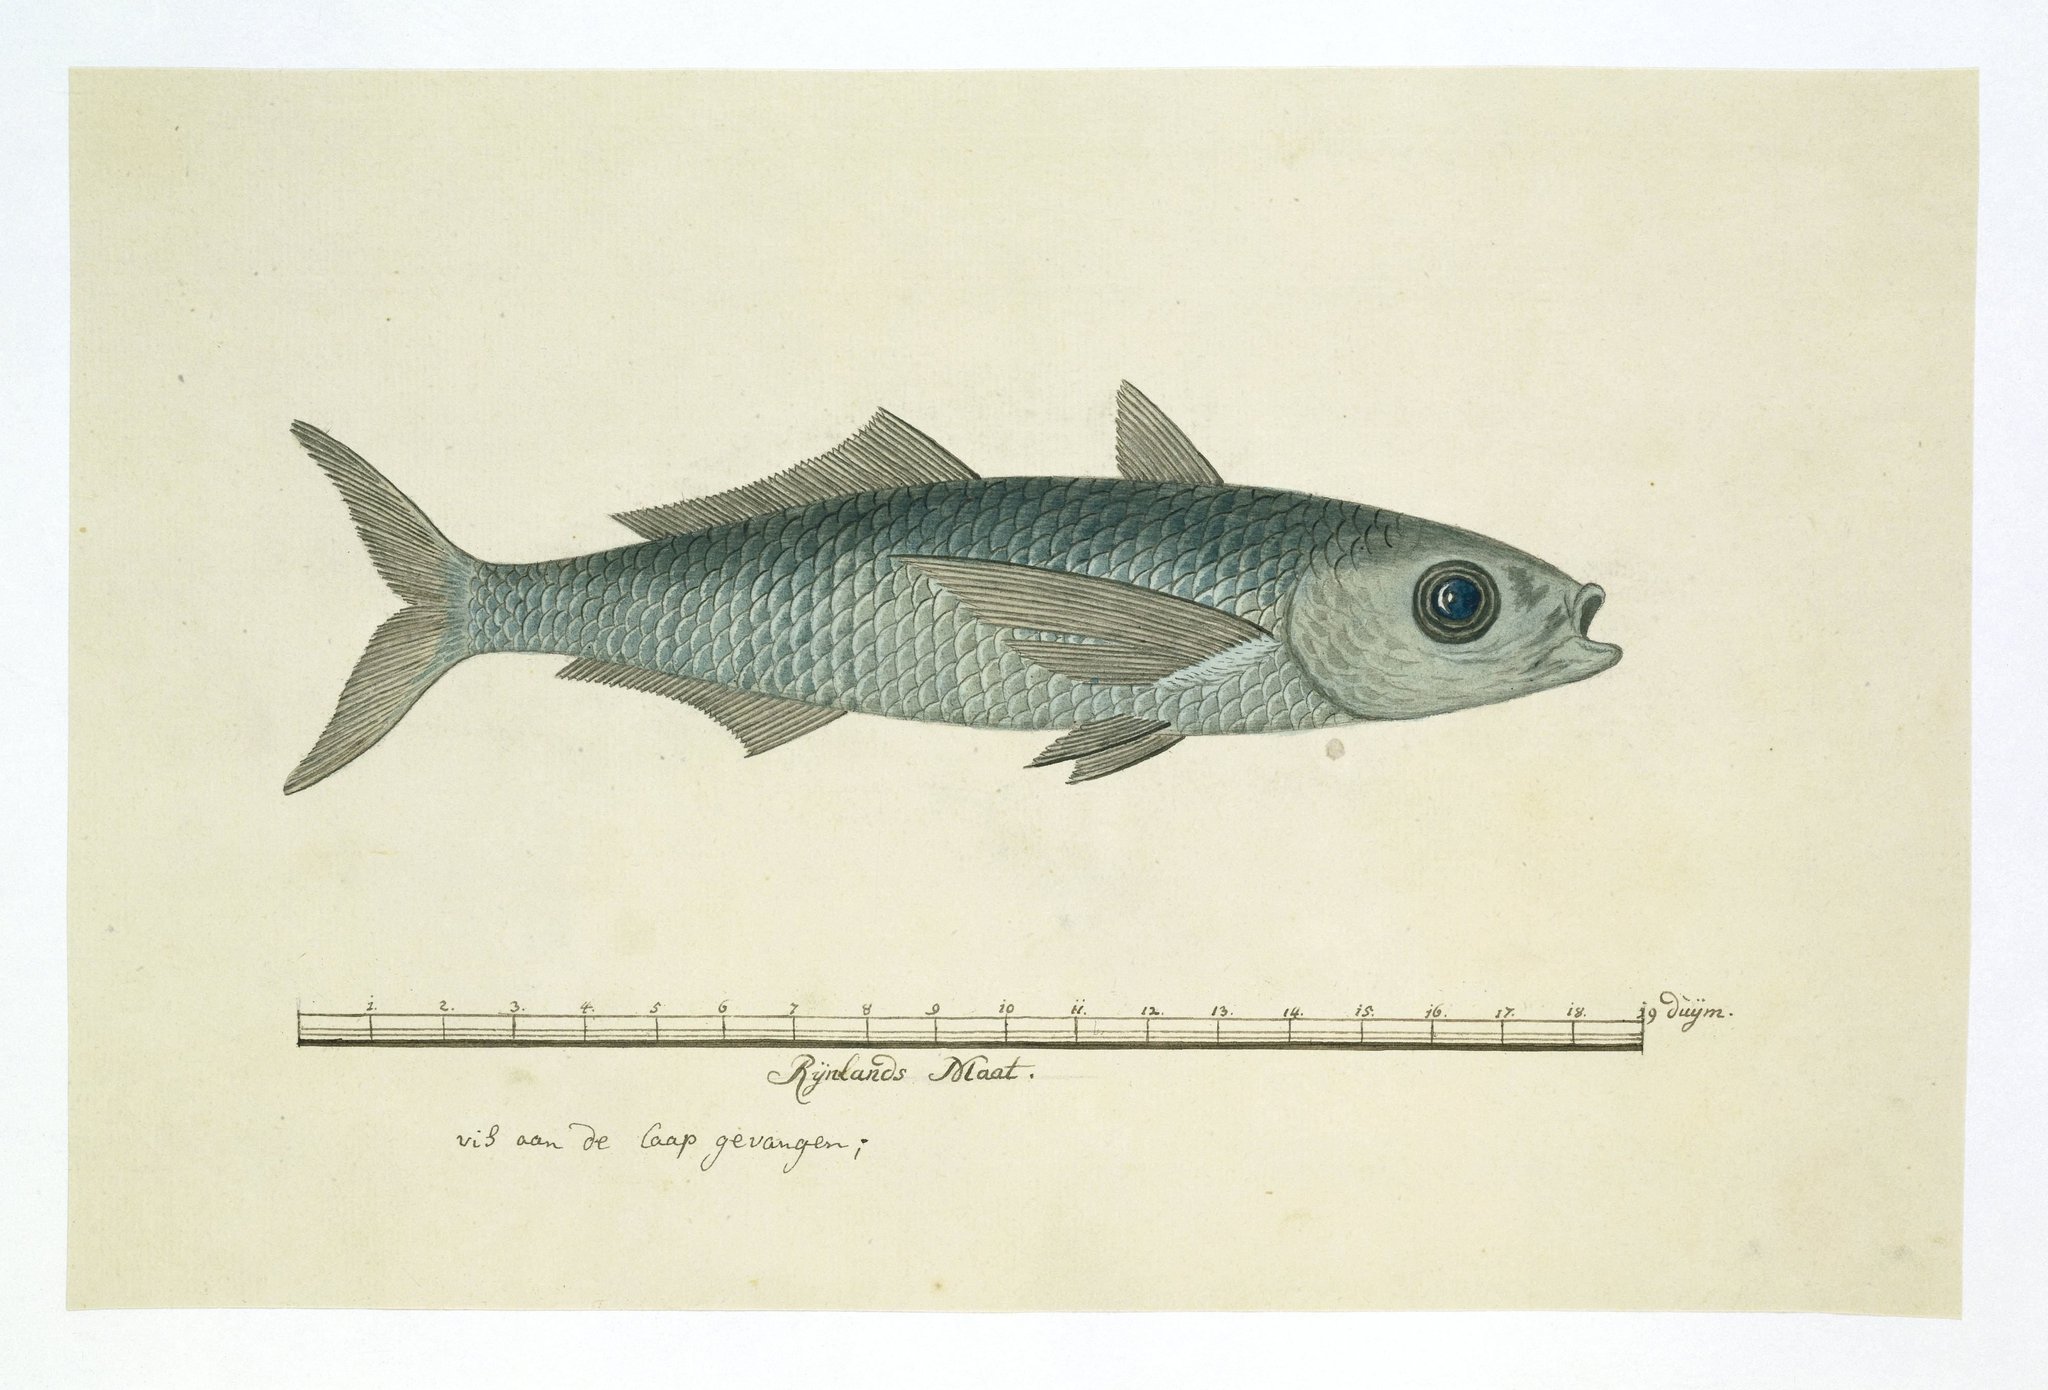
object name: drawing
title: Fish of the order Mugilidae (mullet)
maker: robert jacob gordon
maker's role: draughtsman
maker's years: 1743-1795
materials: chalk, paper, pencil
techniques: brush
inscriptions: annotation: ‘Rijnlands Maat. / vis aan de Caap gevangen.’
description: Een vis (Mugilidae) aan de Kaap gevangen; met een schaalverdeling in Rijnlandse duimen.